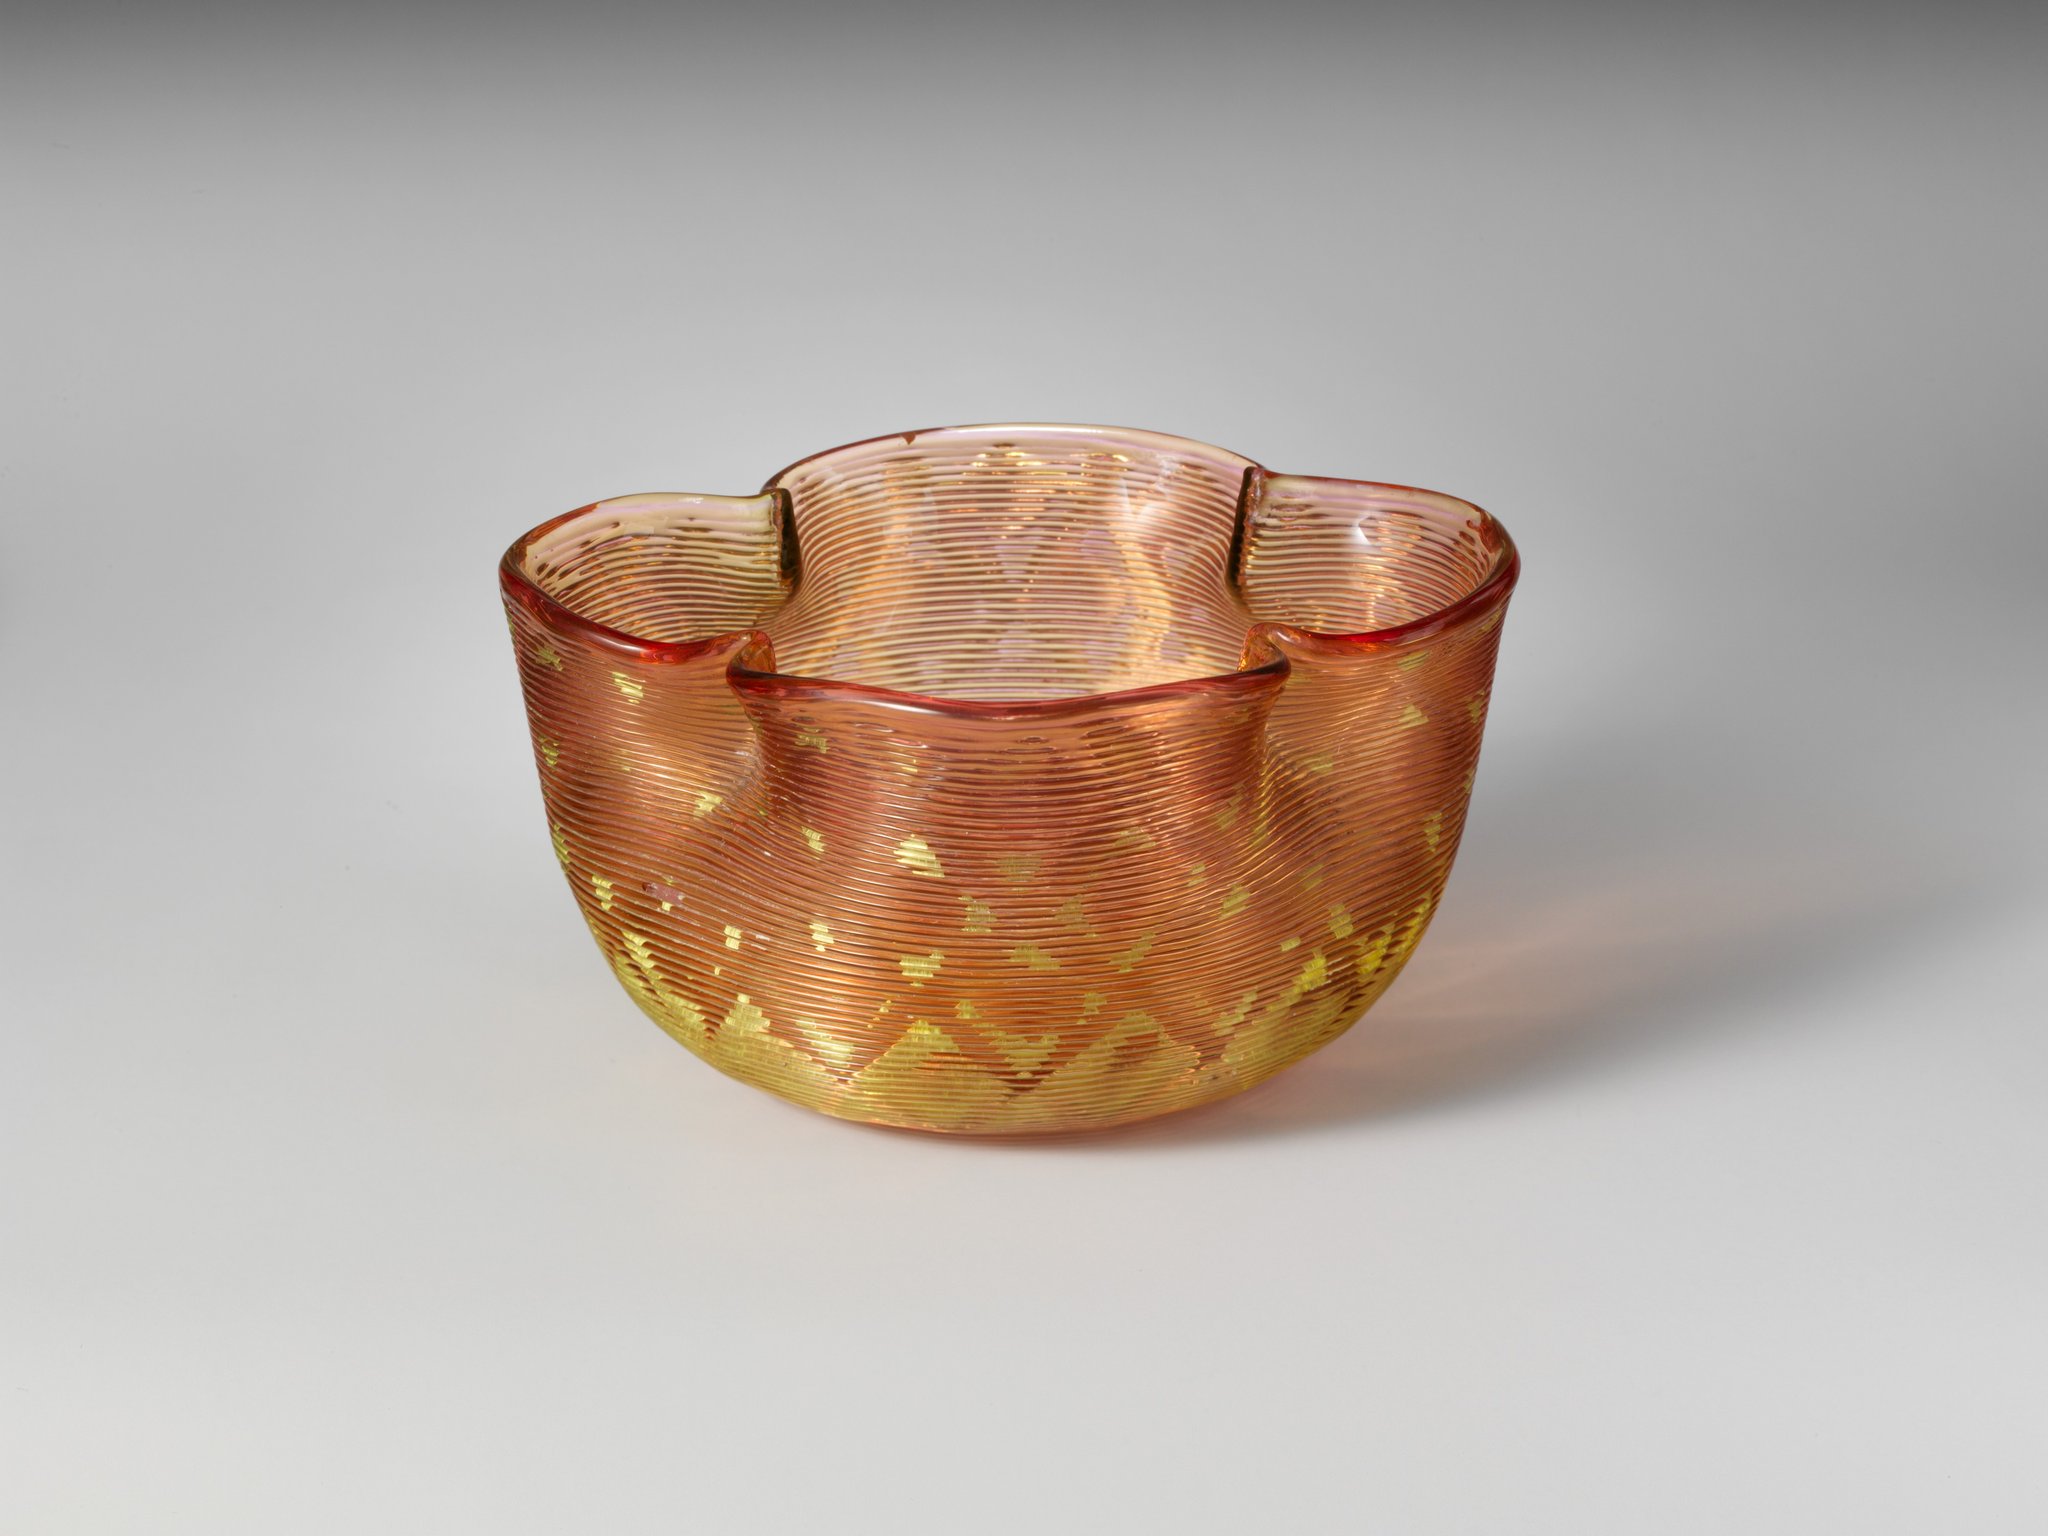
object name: finger bowl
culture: american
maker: boston & sandwich glass company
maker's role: maker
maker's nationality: american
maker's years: 1825-1888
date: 1880-1888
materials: amber, glass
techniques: glassblowing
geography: united states